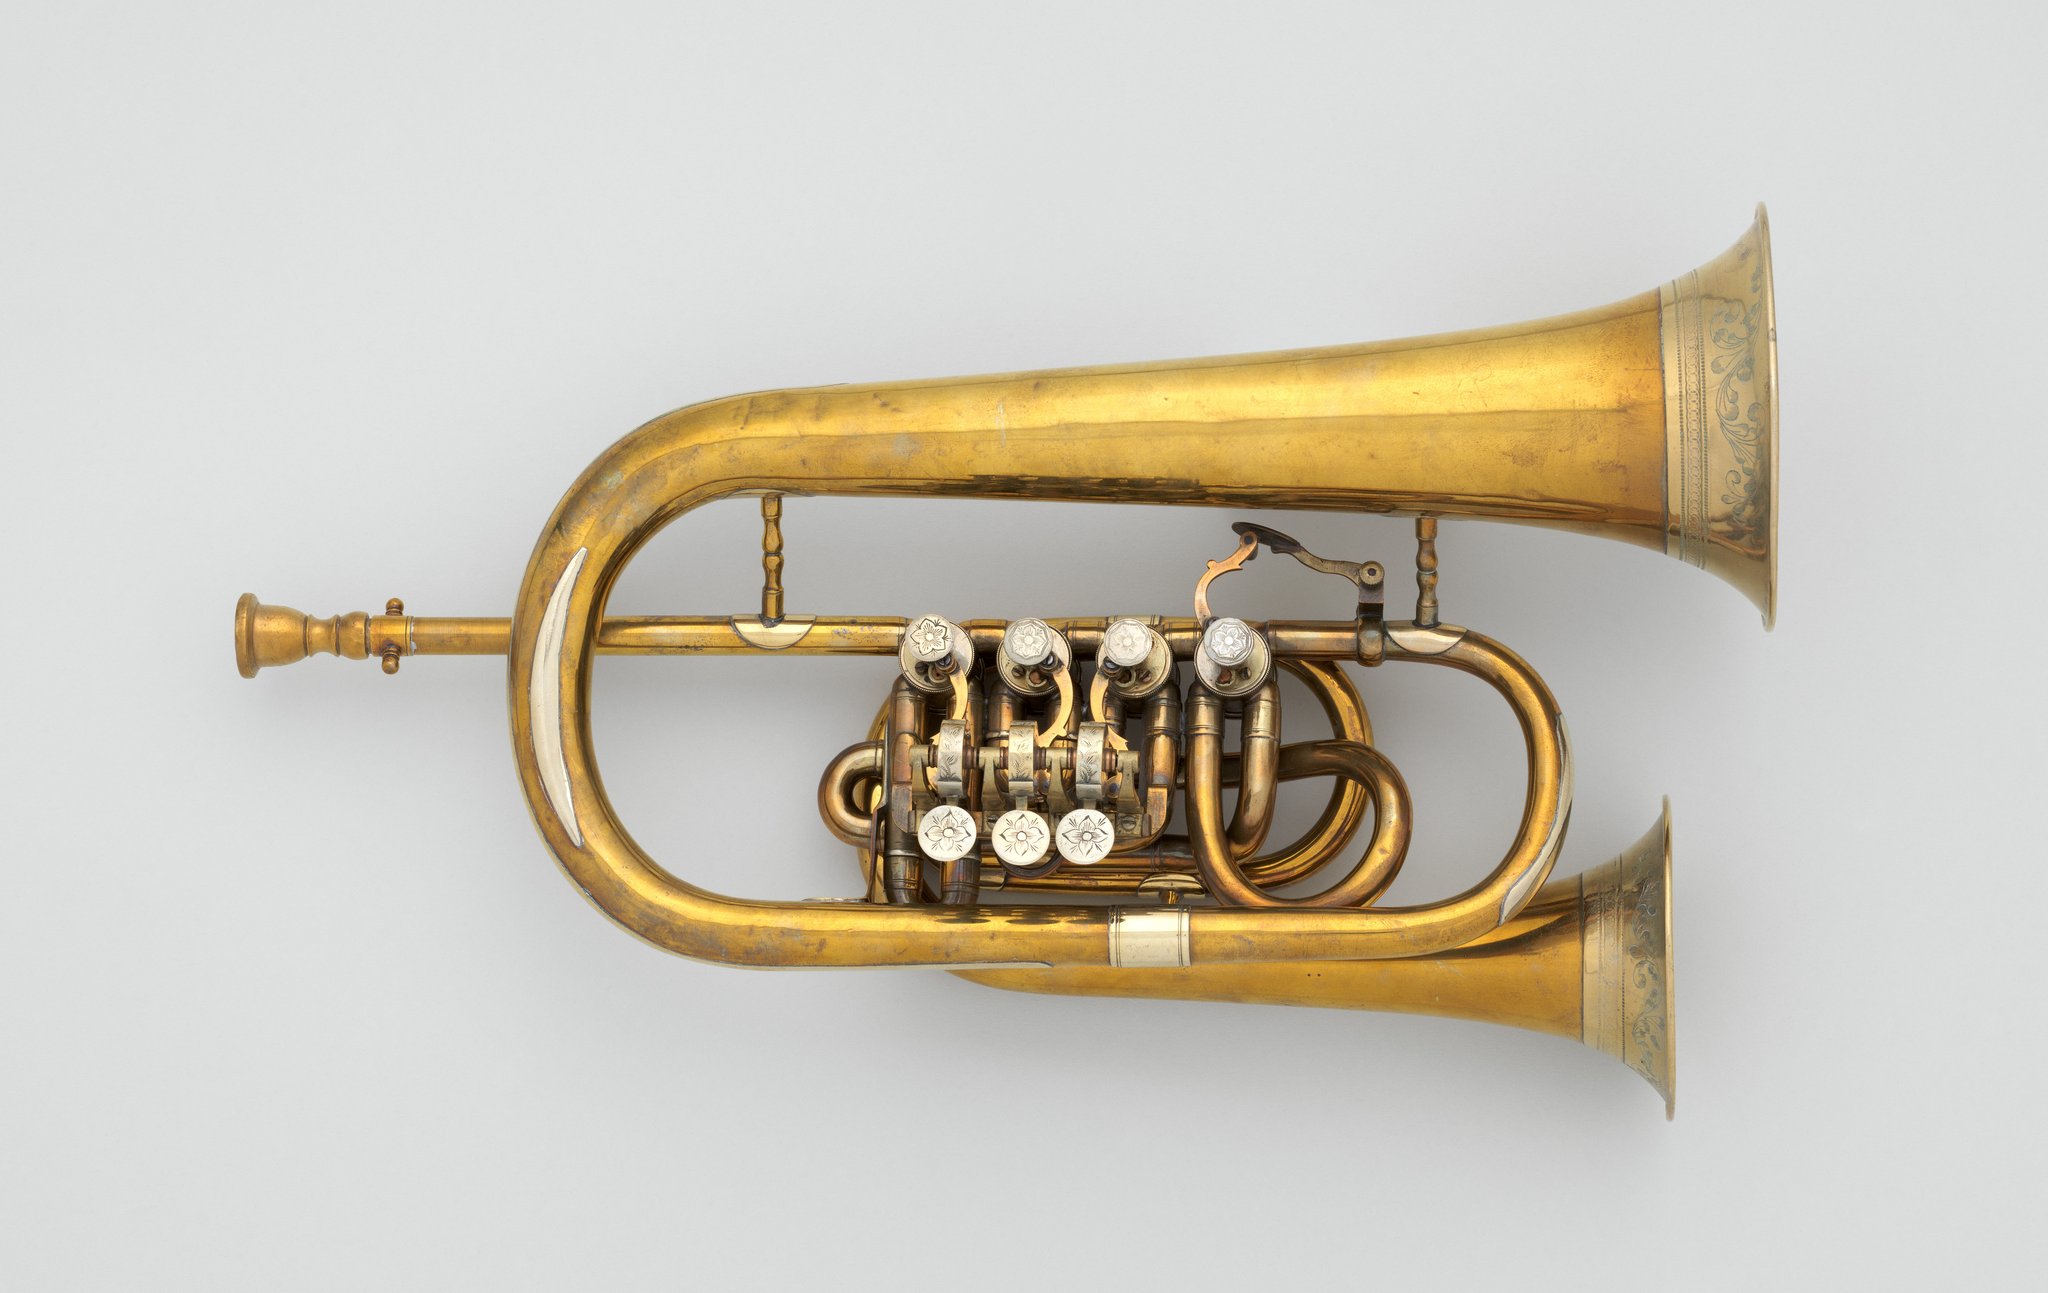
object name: flügel horn with cornet in c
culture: italian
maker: giuseppe pelitti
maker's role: maker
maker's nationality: italian, born varese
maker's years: 1811-1865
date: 1890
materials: brass, nickel, silver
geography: italy